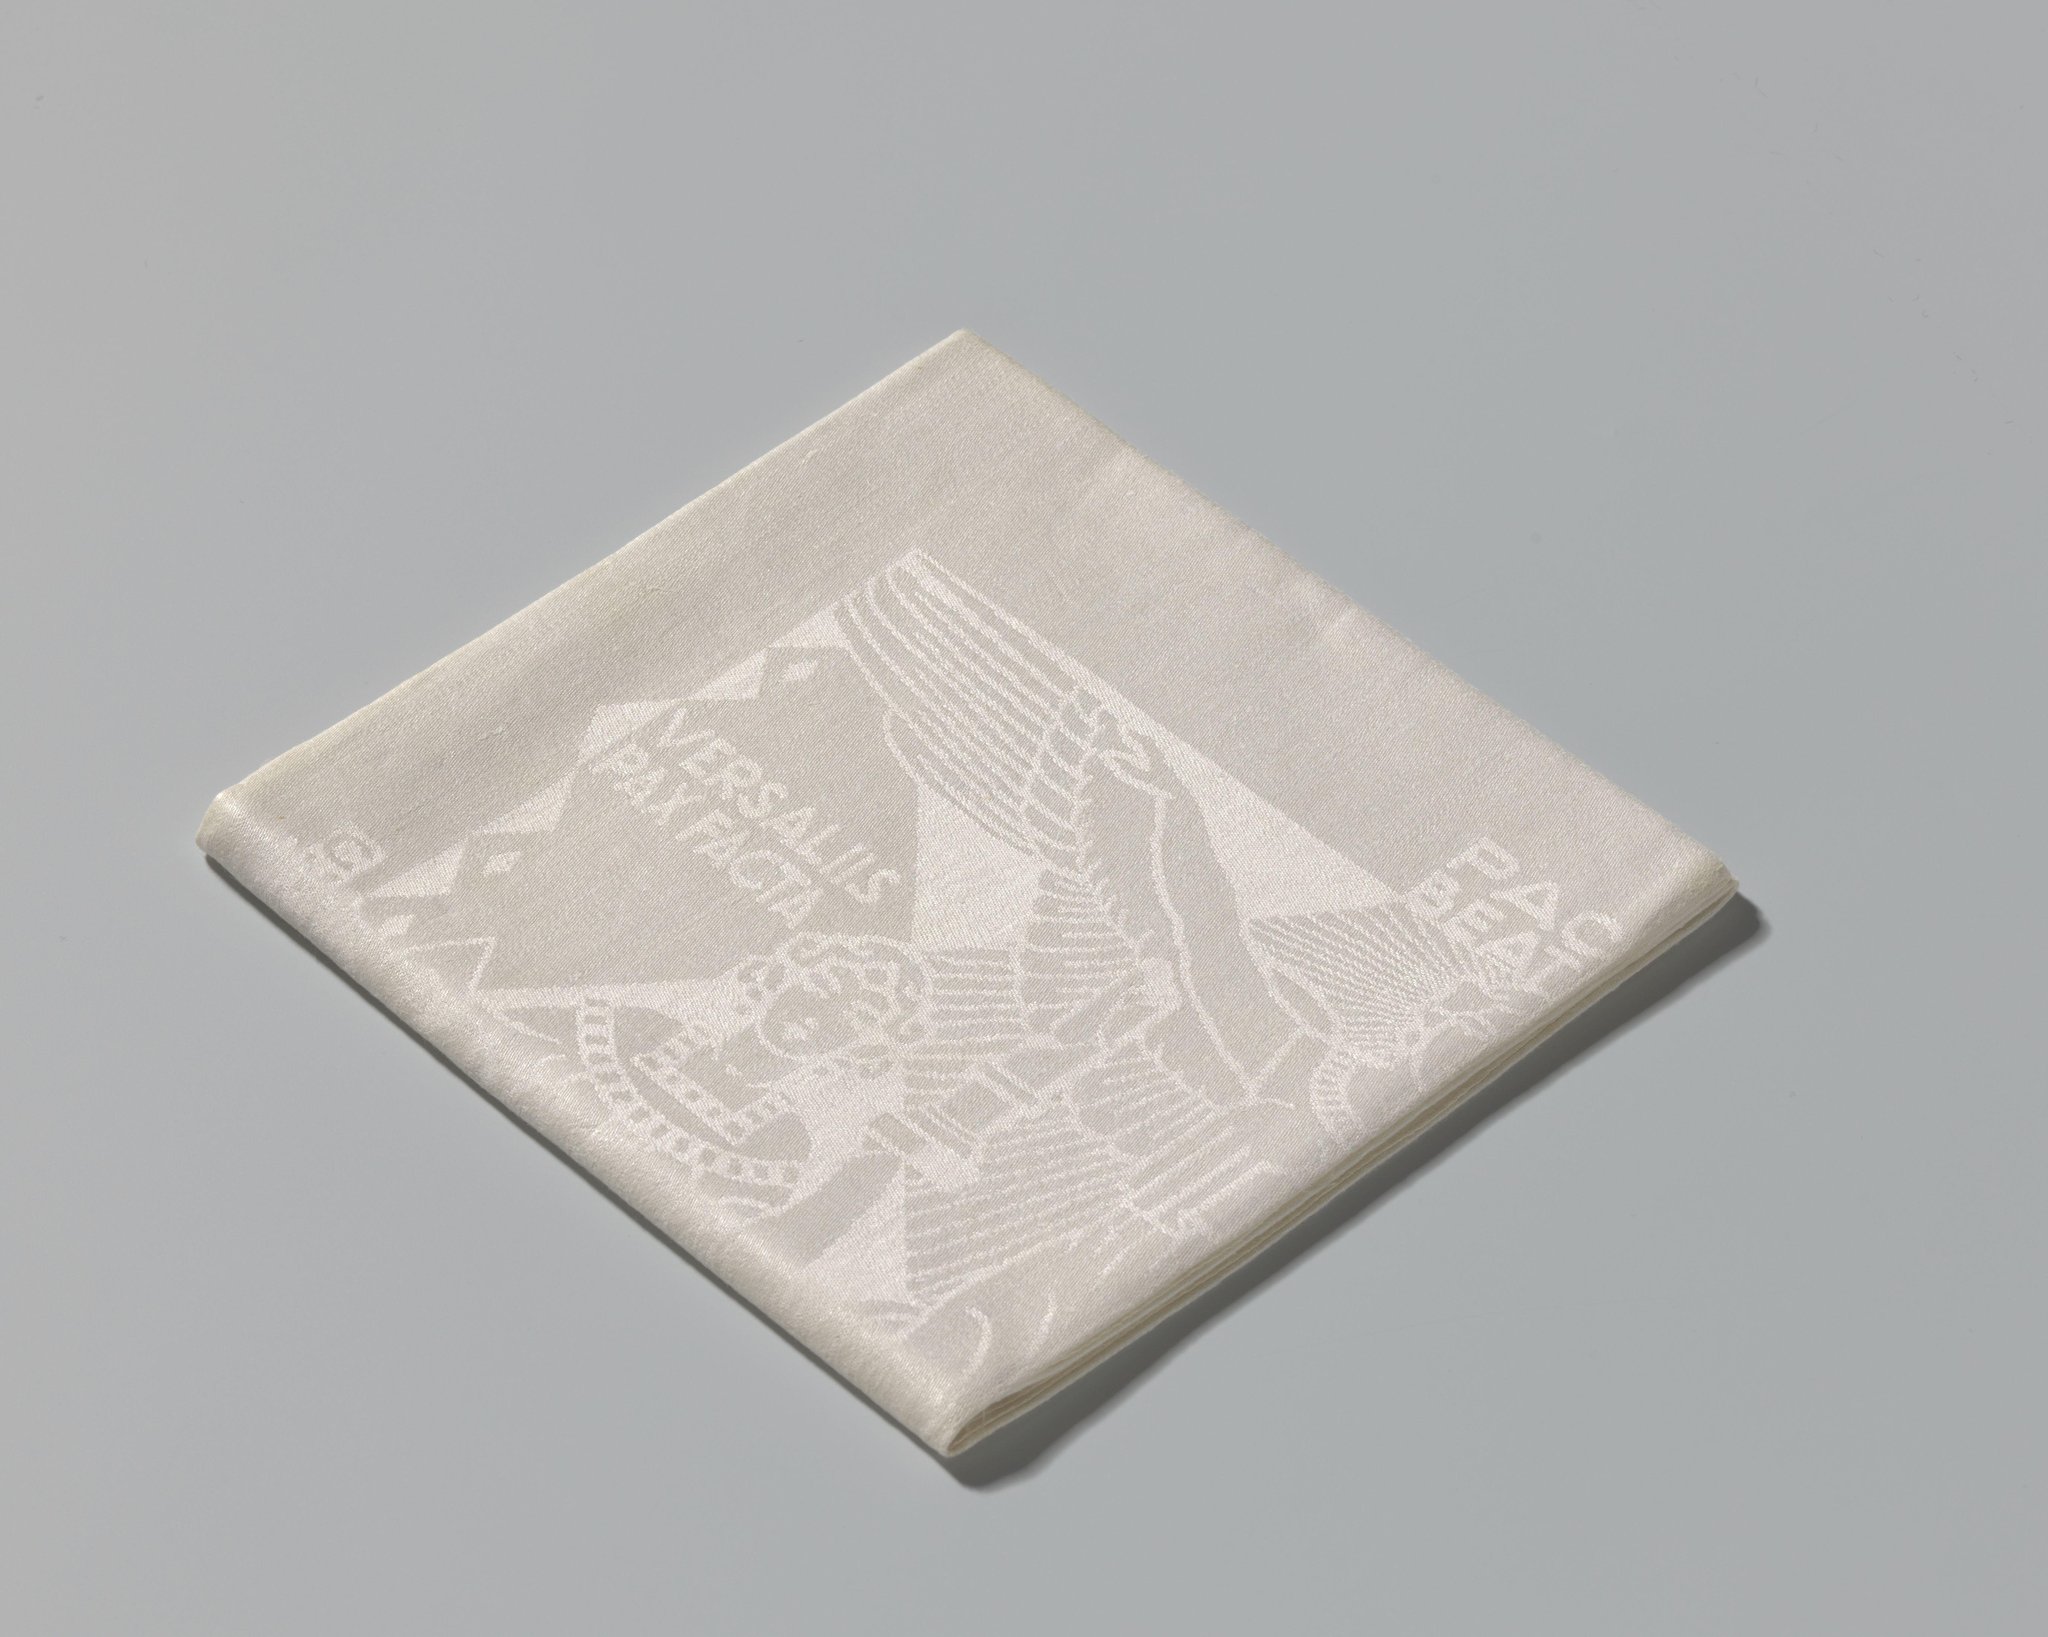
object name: napkin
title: Servet van wit linnendamast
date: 1919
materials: linen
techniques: damask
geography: netherlands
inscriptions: number: ‘558’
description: Wit linnen damasten servet met de Vrede van Versailles.